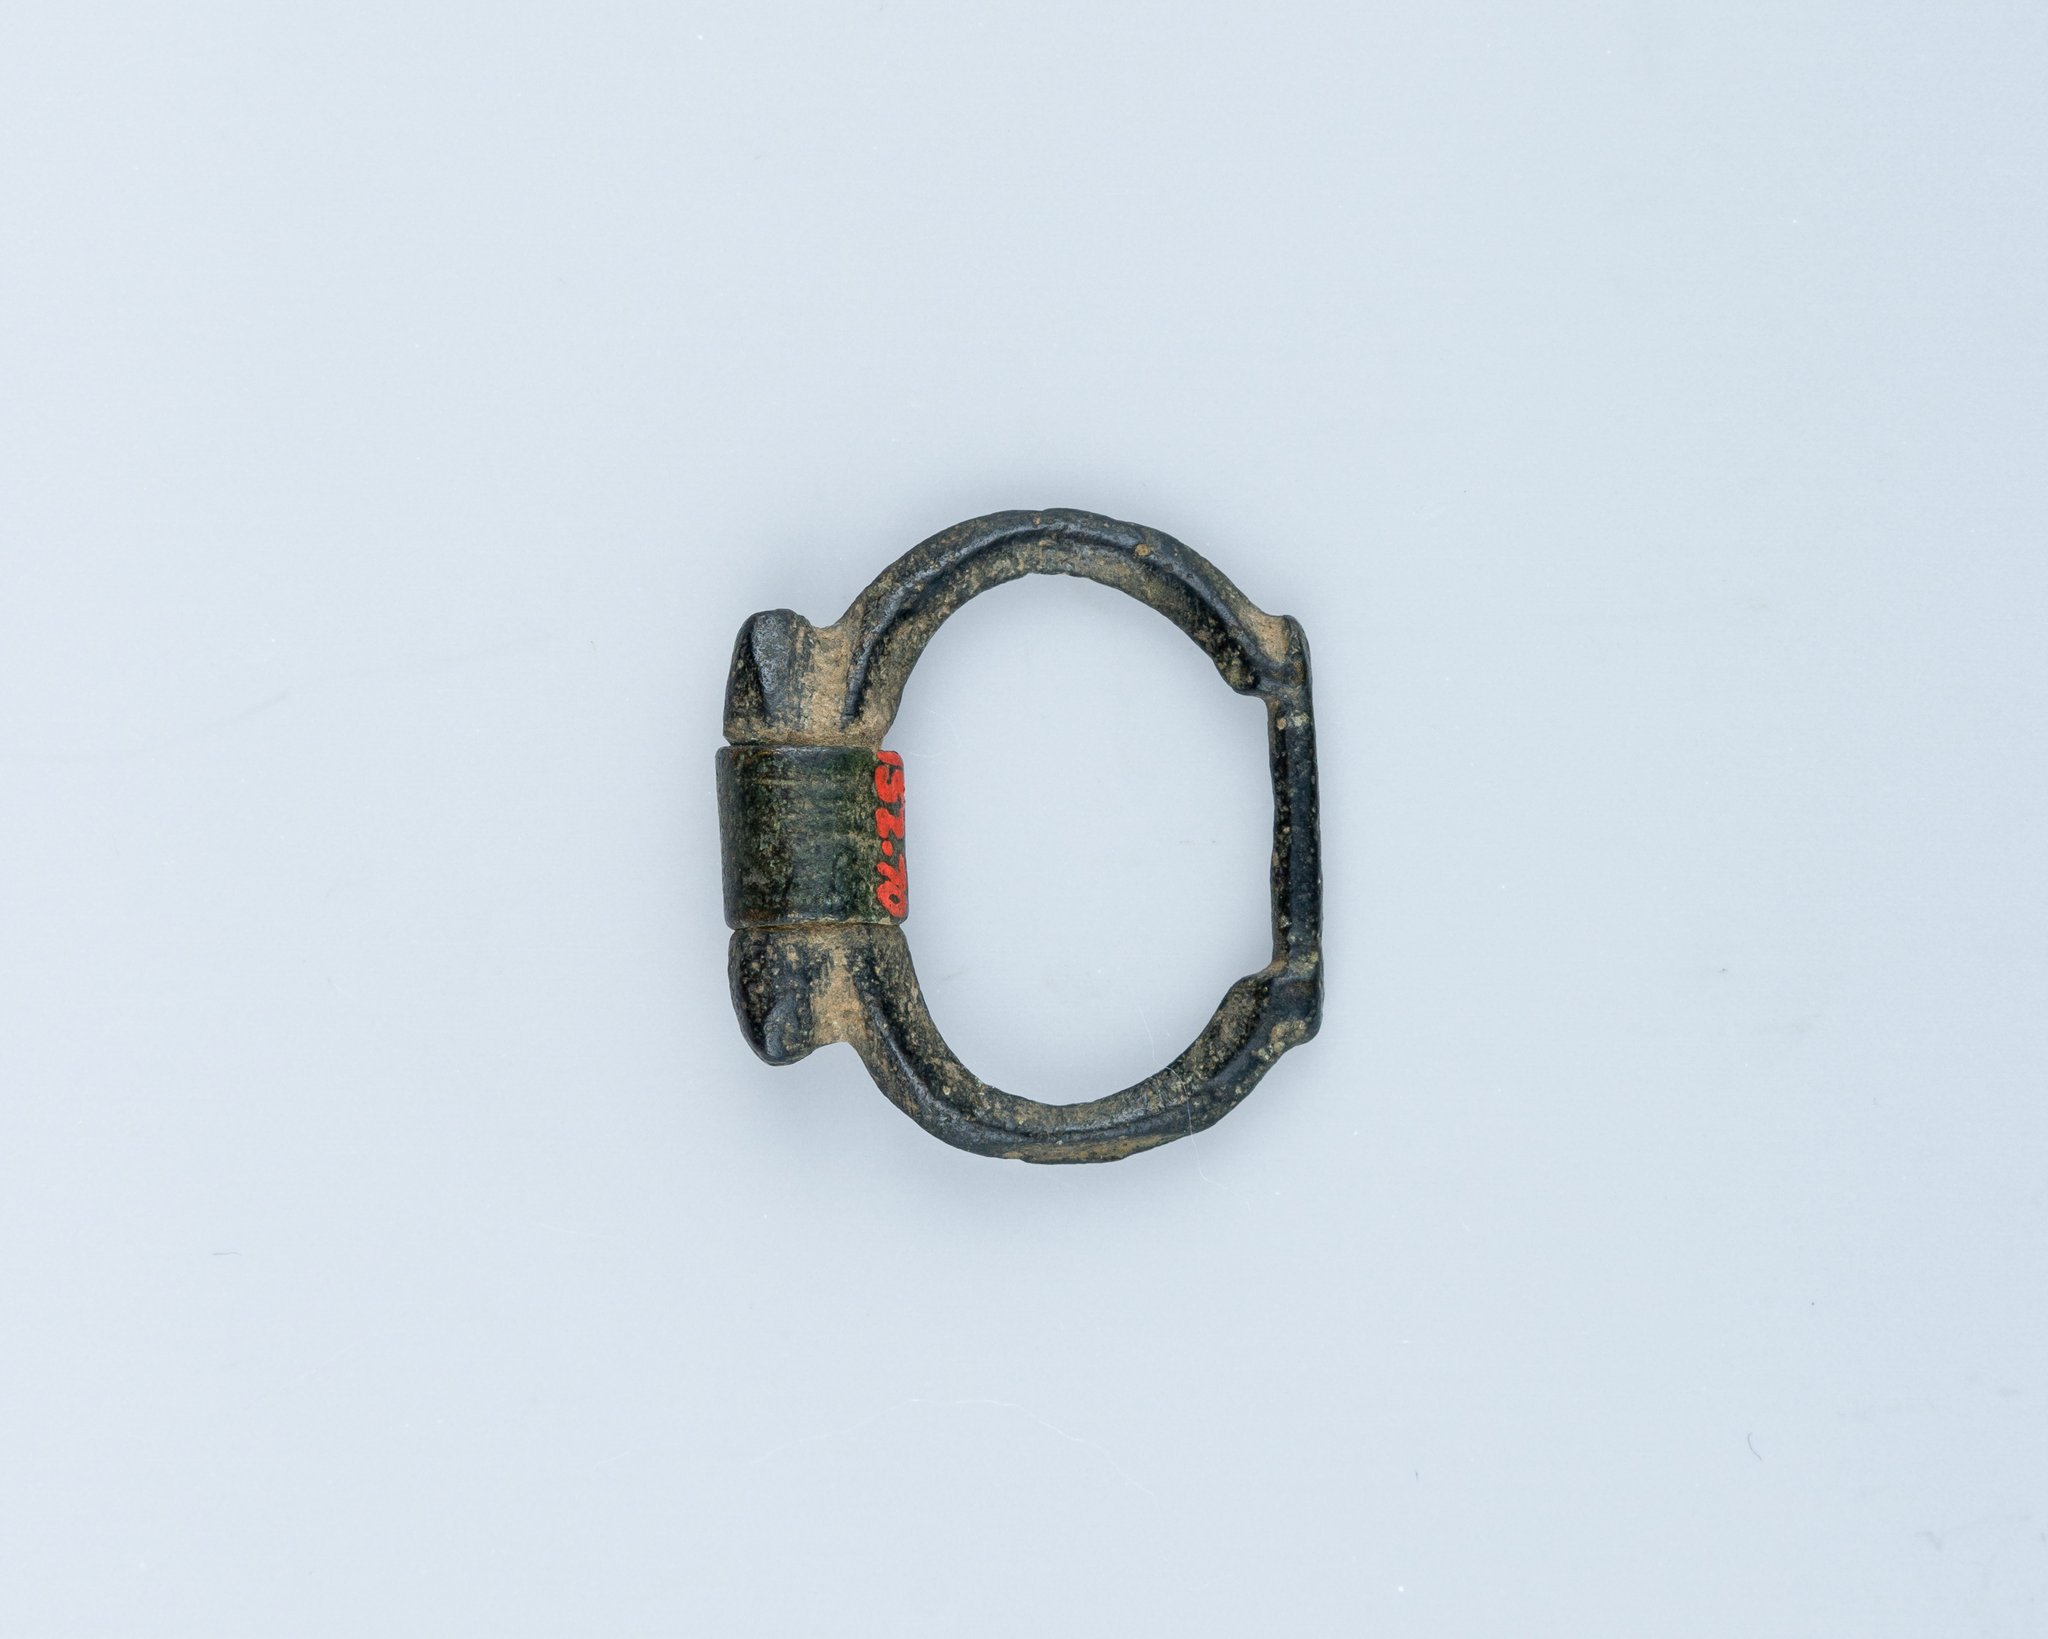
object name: buckle loop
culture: french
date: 1301-1400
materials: bronze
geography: france